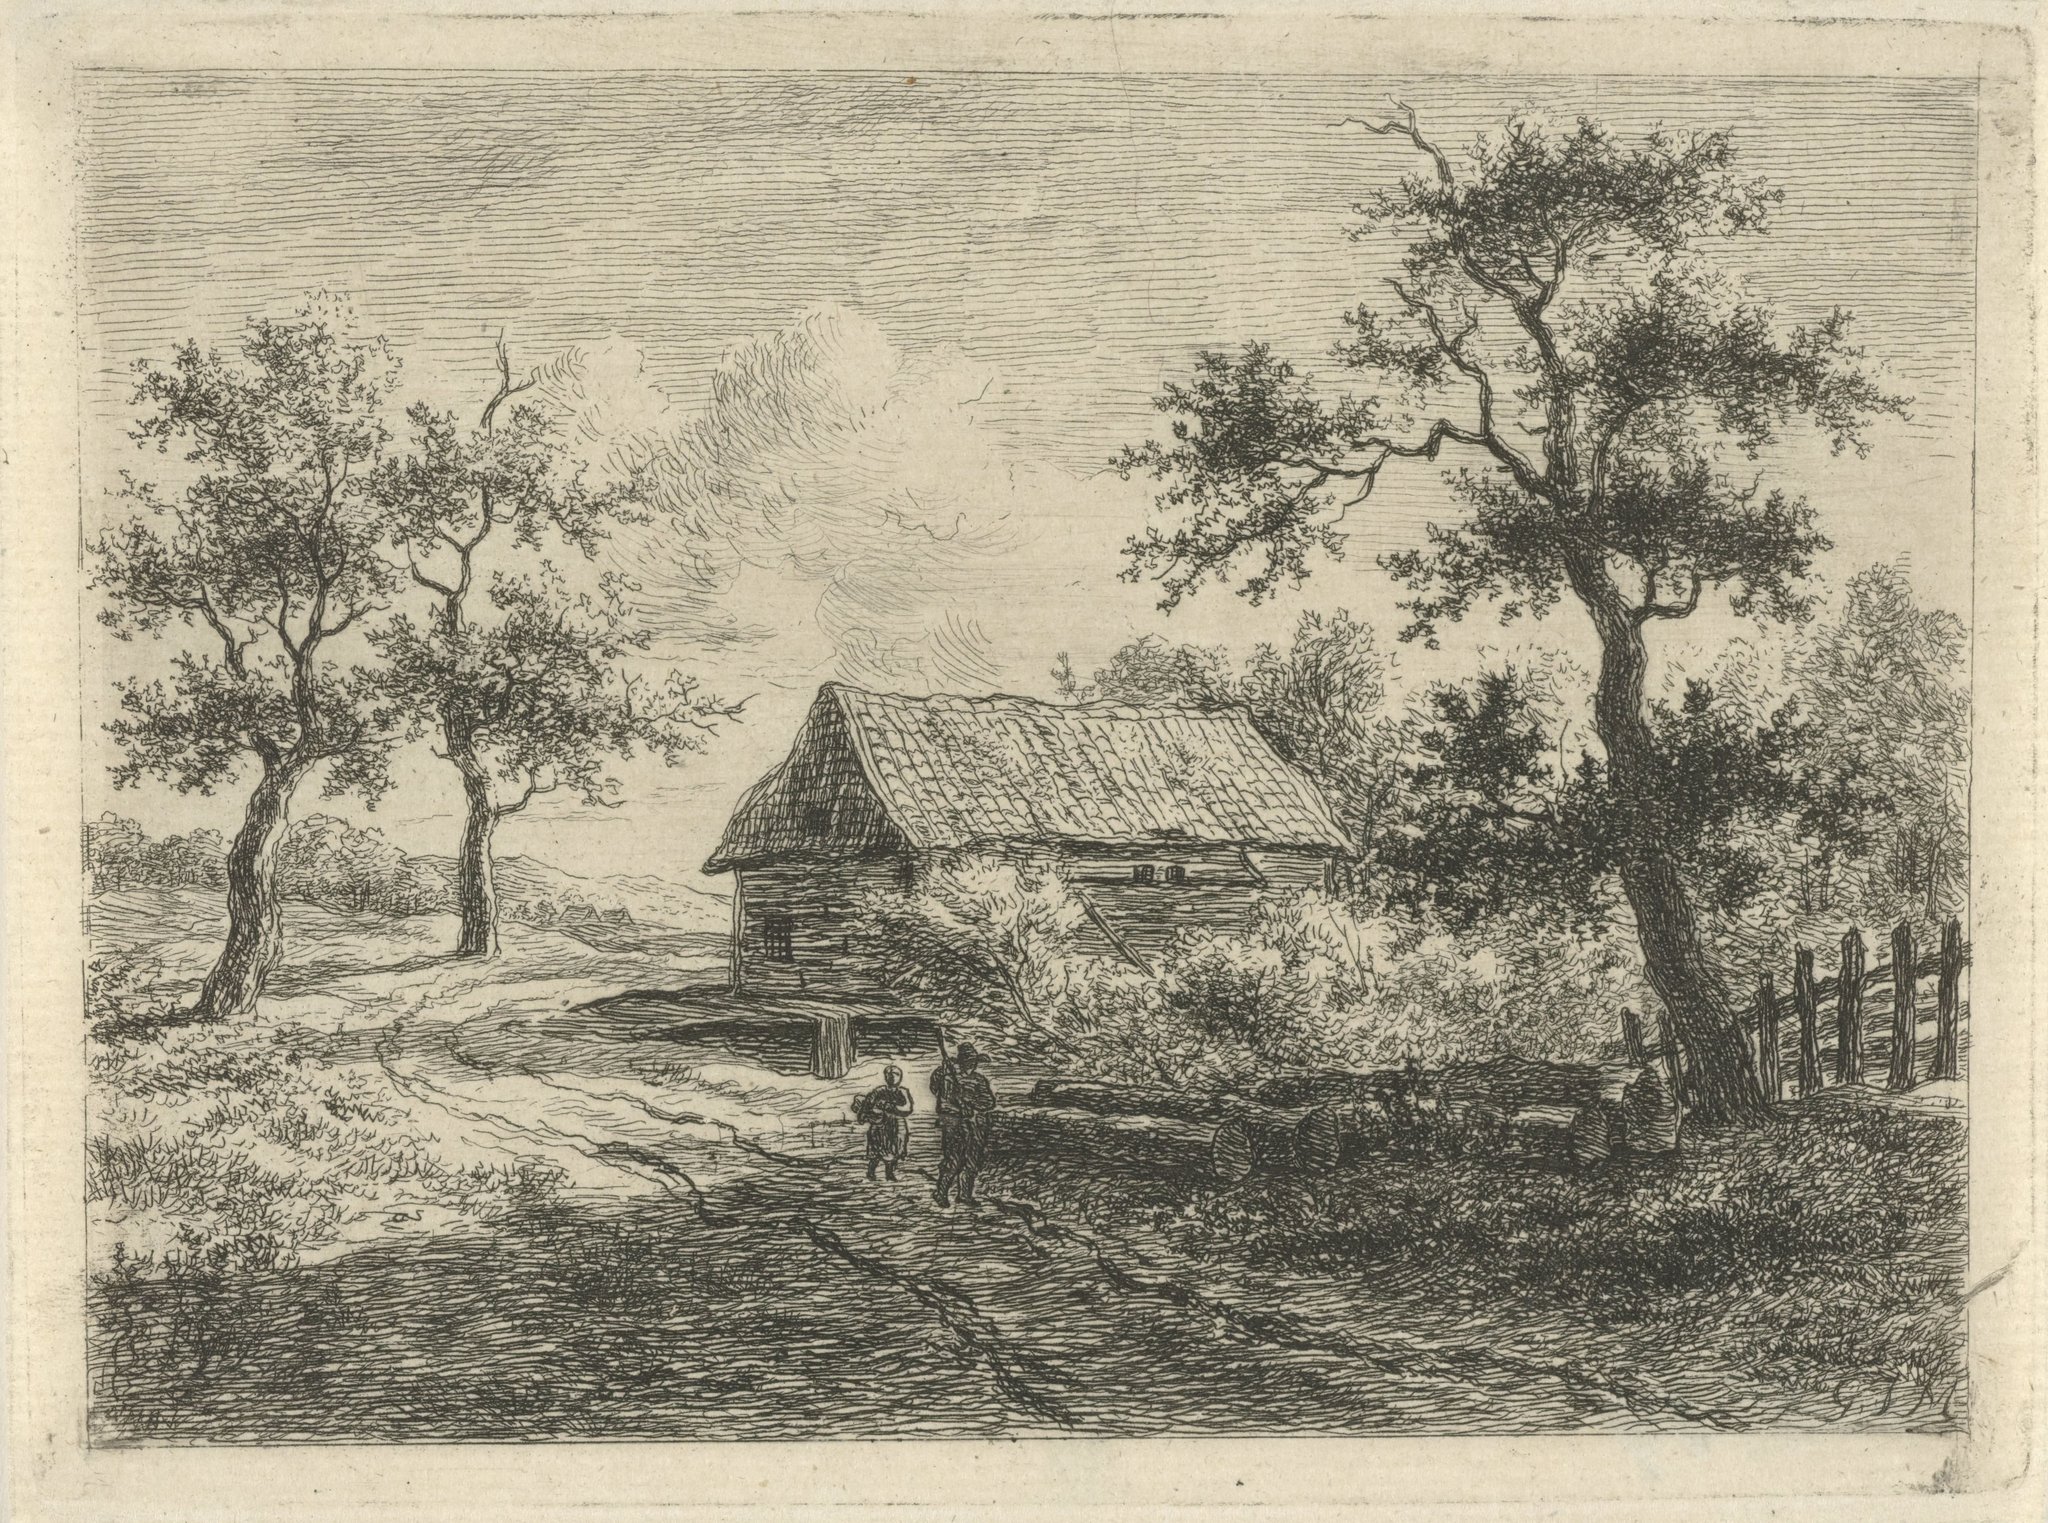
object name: print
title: Landschap met twee figuren op weg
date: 1785-1857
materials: paper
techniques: etching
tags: trees, landscapes (+ landscape with figures, staffage), farm or solitary house in landscape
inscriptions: collector's mark: Lugt 2228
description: Op een weg lopen een man en een kind langs enkele boomstammen. Op de achtergrond bomen en een boerderij.